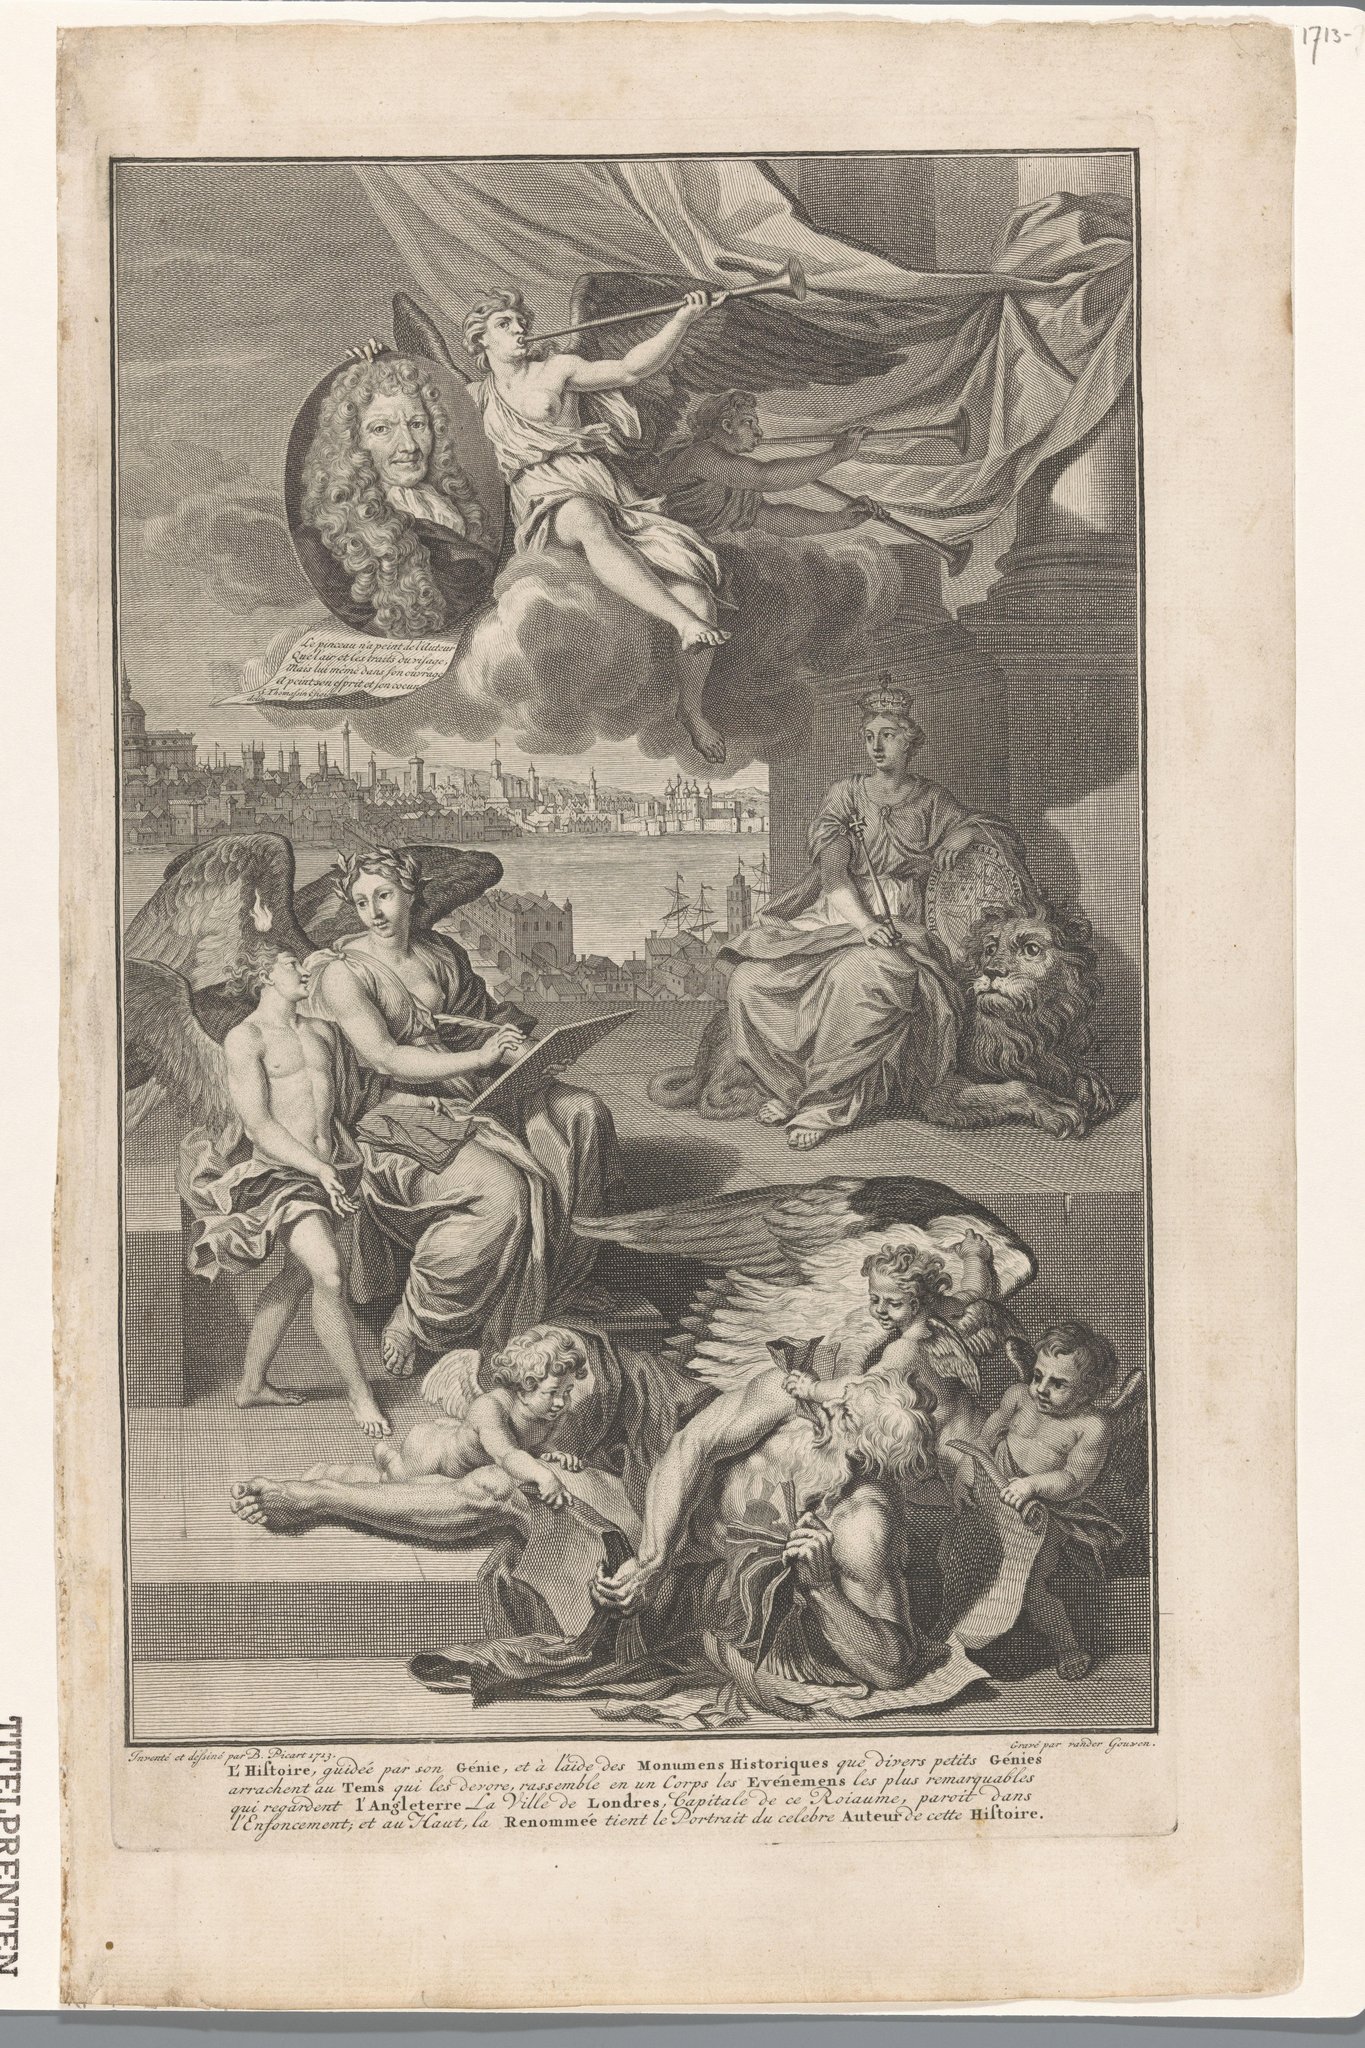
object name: print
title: Titelpagina voor: Isaac de Larrey, Histoire d'Angleterre, 1713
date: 1713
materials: paper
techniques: engraving, etching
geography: rotterdam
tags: berlin, personifications of countries, nations, states, districts, etc., portrait of a writer, 'historia'; 'historia' (ripa)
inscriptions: collector's mark: Lugt 2228, collector's mark: Lugt 2760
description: De personificatie van Geschiedenis, gezeten op de vloer, schrijft samen met de personificatie van Inspiratie de geschiedenis van Groot-Brittannië. Rechts bij een zuil de personificatie van Groot-Brittannië, zittend op een leeuw. In haar handen het wapenschild van Engeland, gebruikt door Karel II en Jacobus II. Op de voorgrond trachten drie putti de gevleugelde Tijd tegen te houden, die boeken verscheurt en opeet. Boven de personificatie van Faam, blazend op een bazuin. Ze draagt het portret in ovale lijst van de Franse historicus Isaac de Larrey. Op de achtergrond de stad Londen. In de ondermarge een vierregelige Franse tekst.